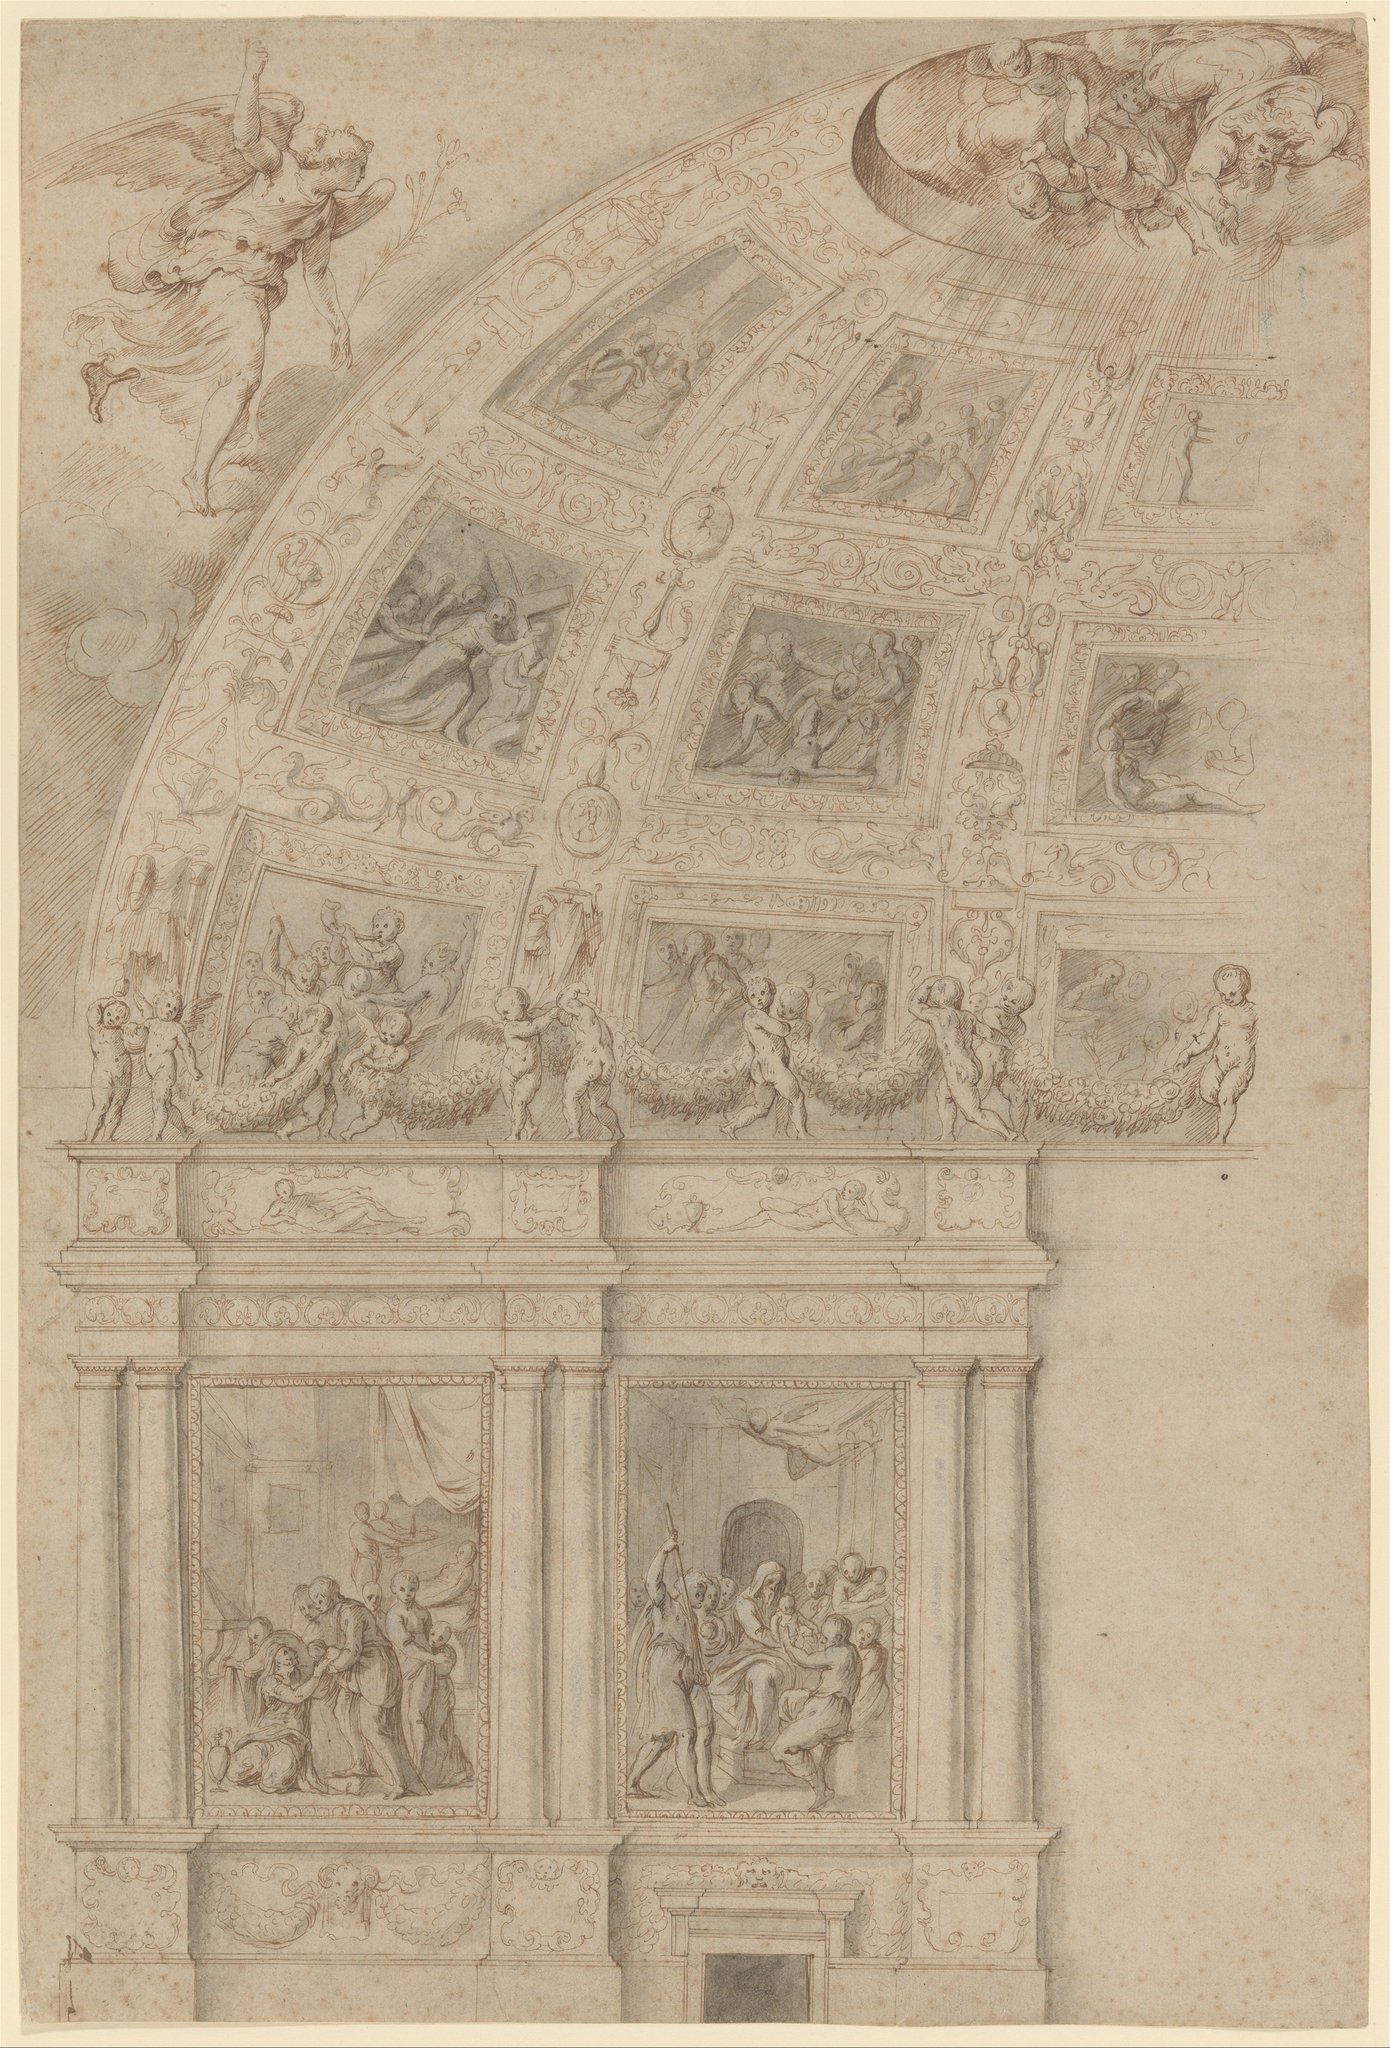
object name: drawing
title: Design for the Decoration of the Semi-Dome of a Church Apse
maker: battista franco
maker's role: artist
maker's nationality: italian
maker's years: 1510-1561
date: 1545-1555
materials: chalk, ink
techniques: brush, pen, wash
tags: architecture,domes